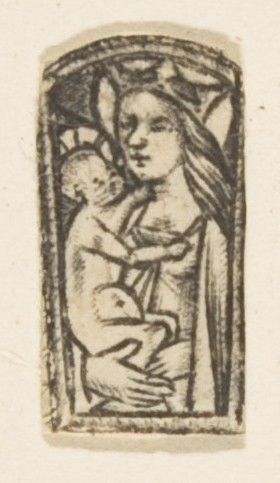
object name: print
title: Virgin and Child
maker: anonymous, german, 15th century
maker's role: artist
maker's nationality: german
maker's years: 1400-1500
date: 1401-1500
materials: niello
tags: madonna and child